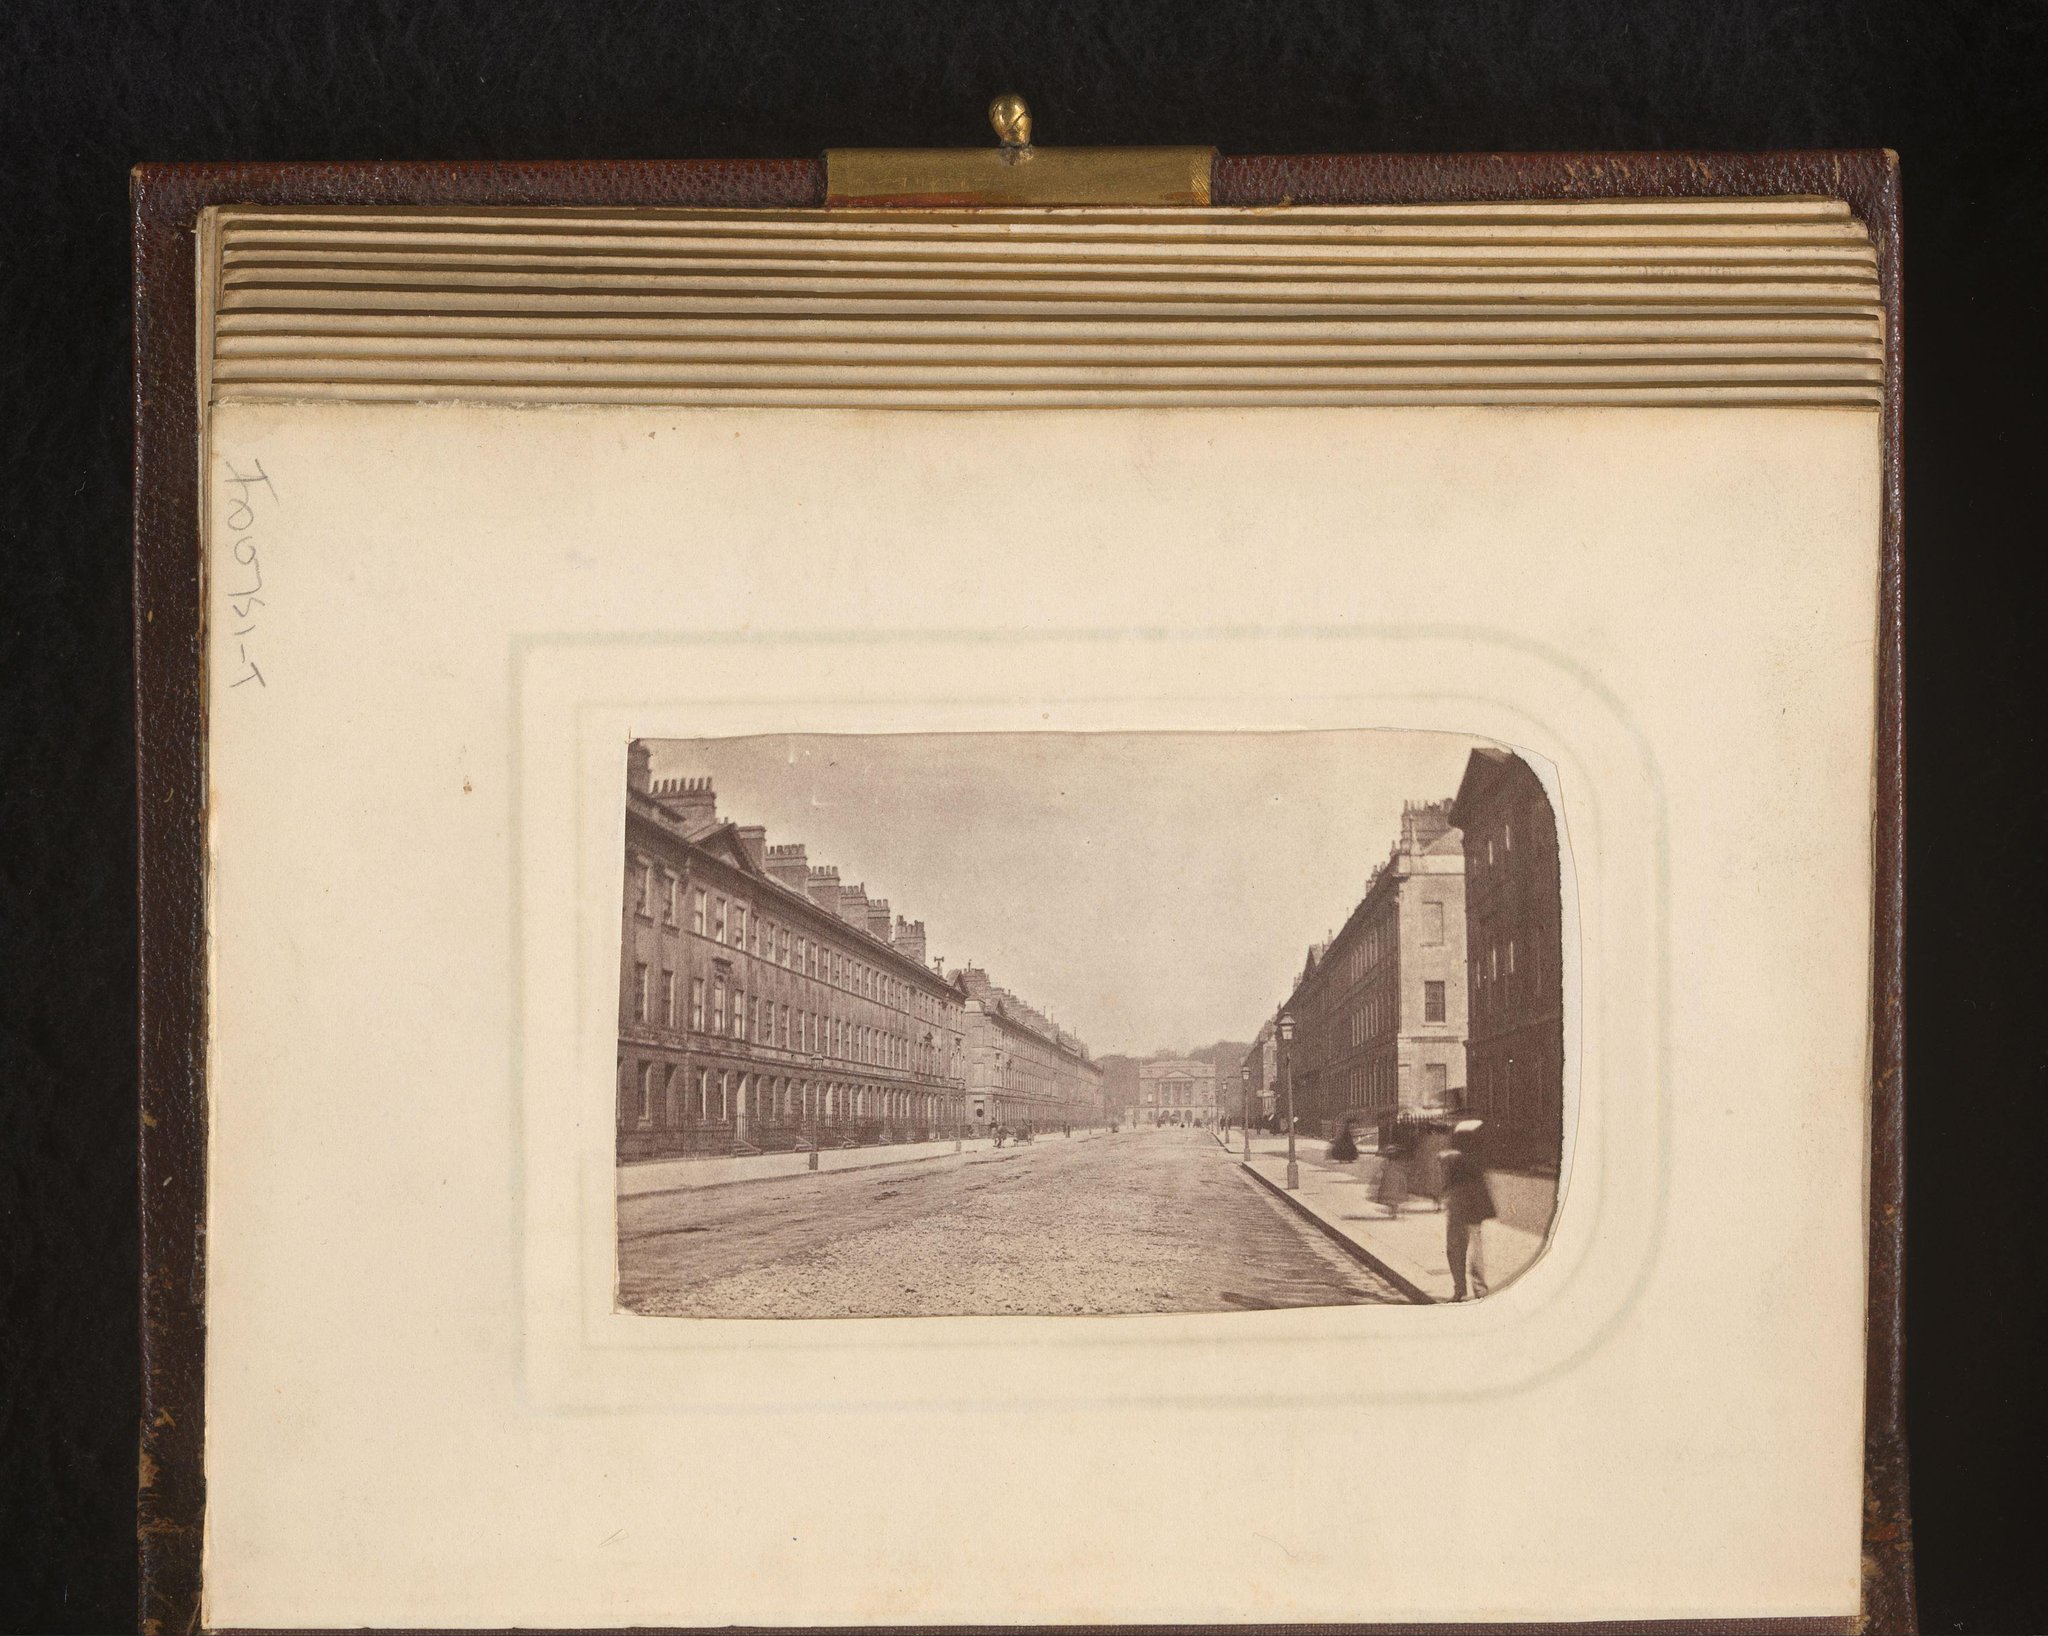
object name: carte de visite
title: Straatgezicht te Bath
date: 1860-1900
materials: cardboard, photographic support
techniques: albumen print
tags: street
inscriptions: inscription: ‘44 Milsom Street, Bath’